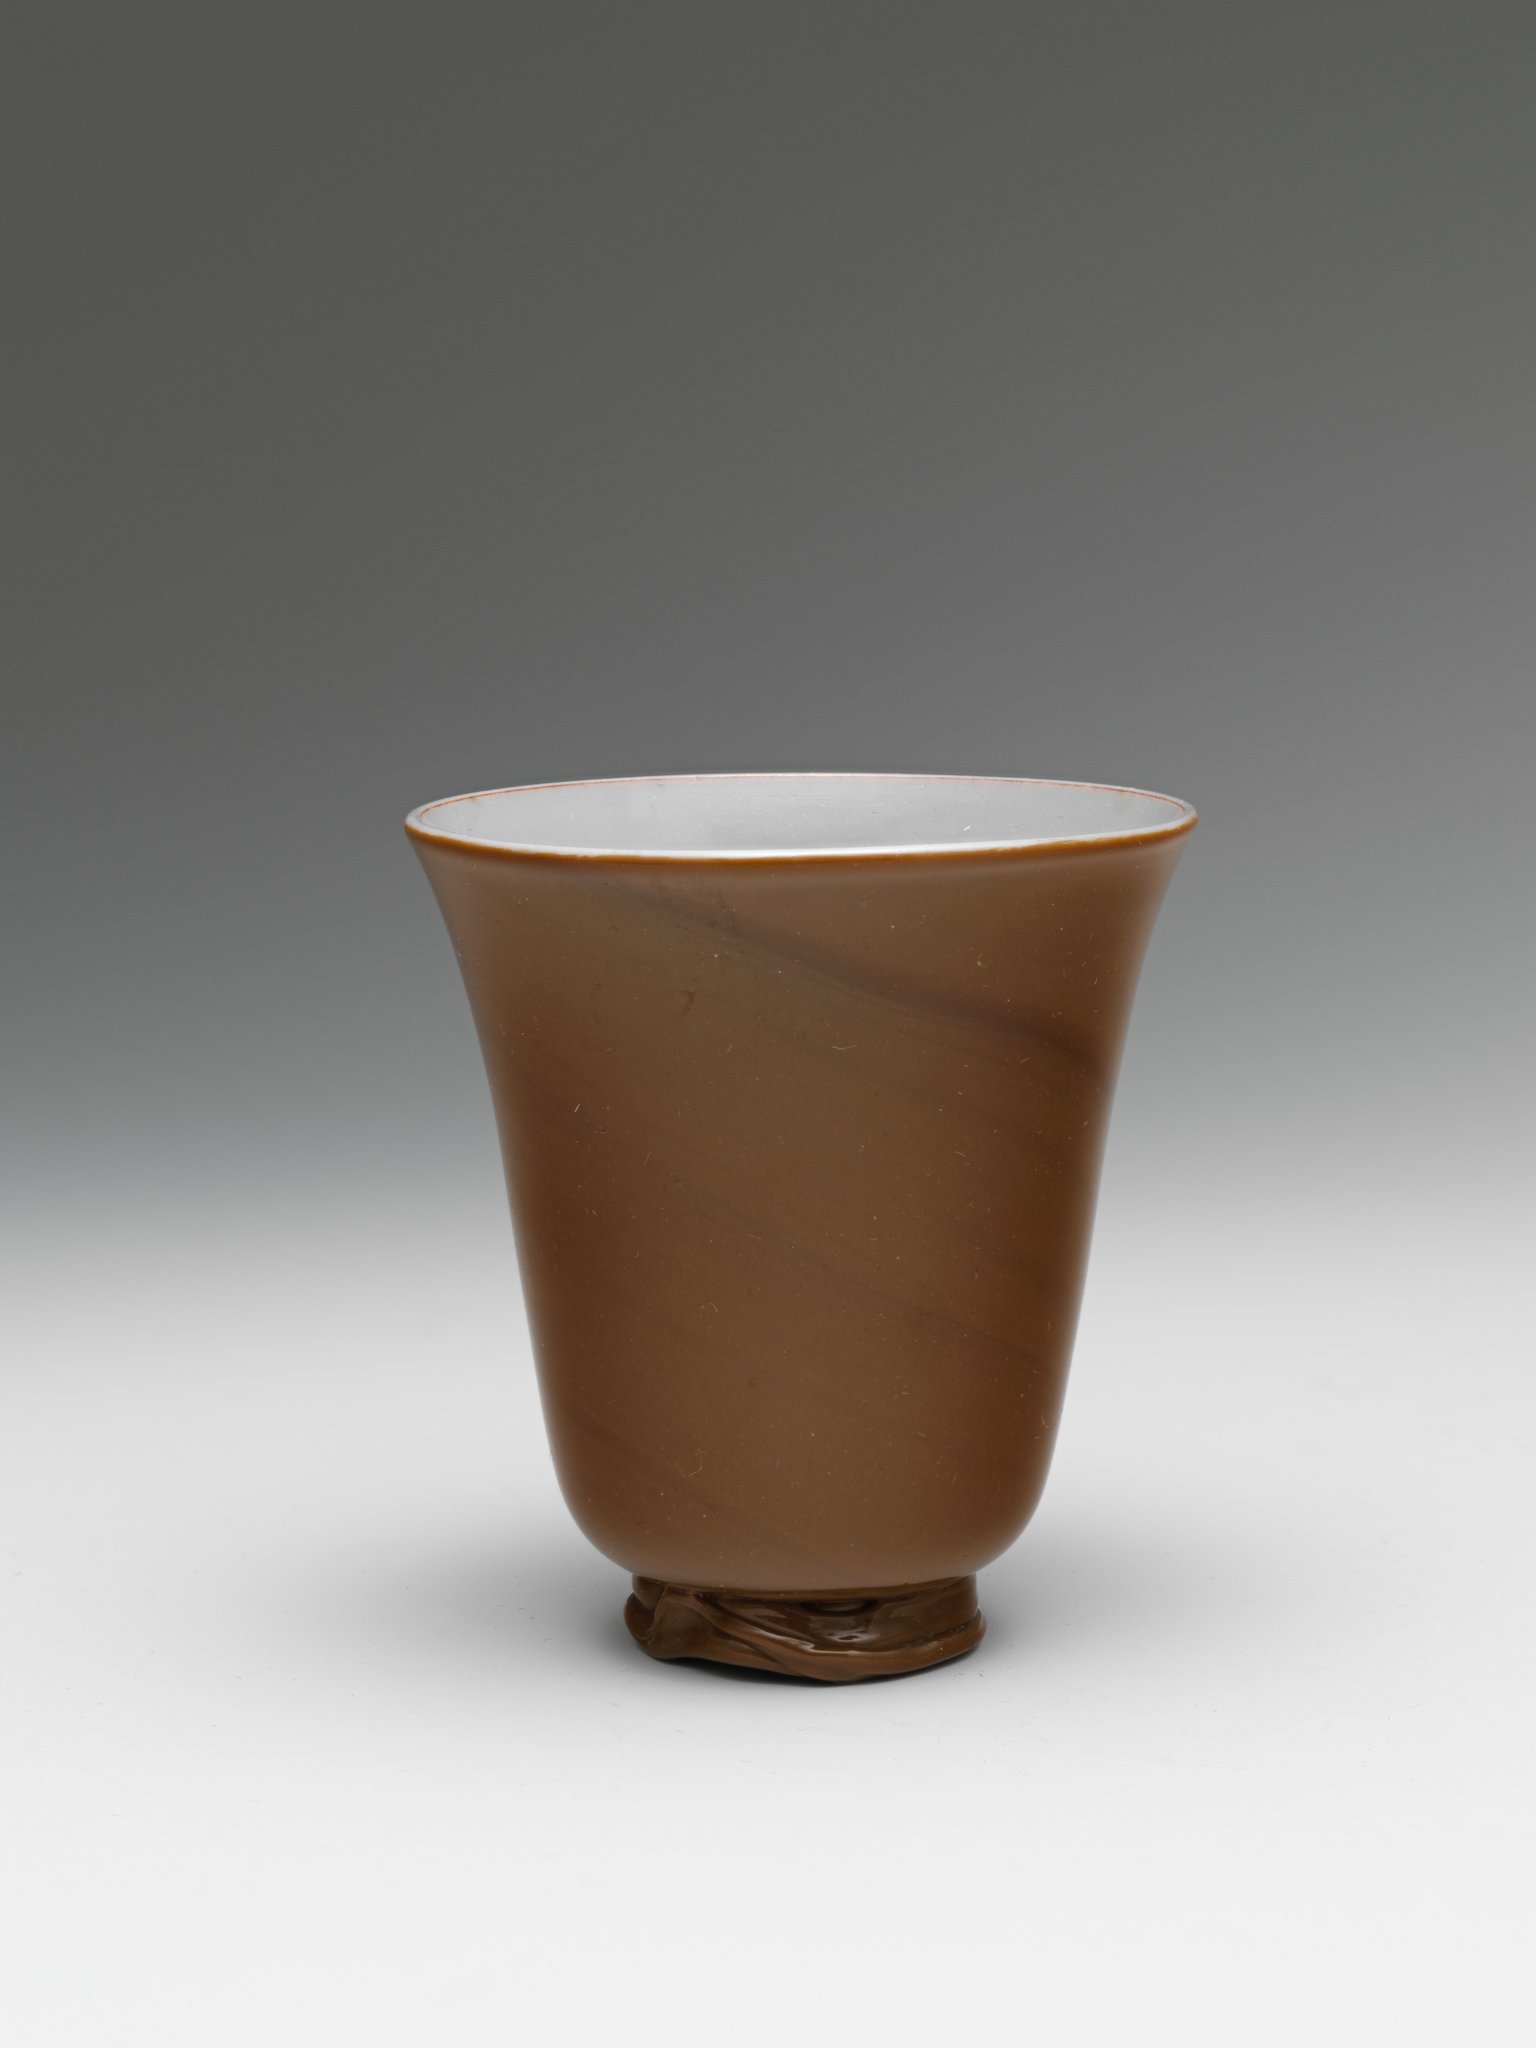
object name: cup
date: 1701-1750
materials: glass